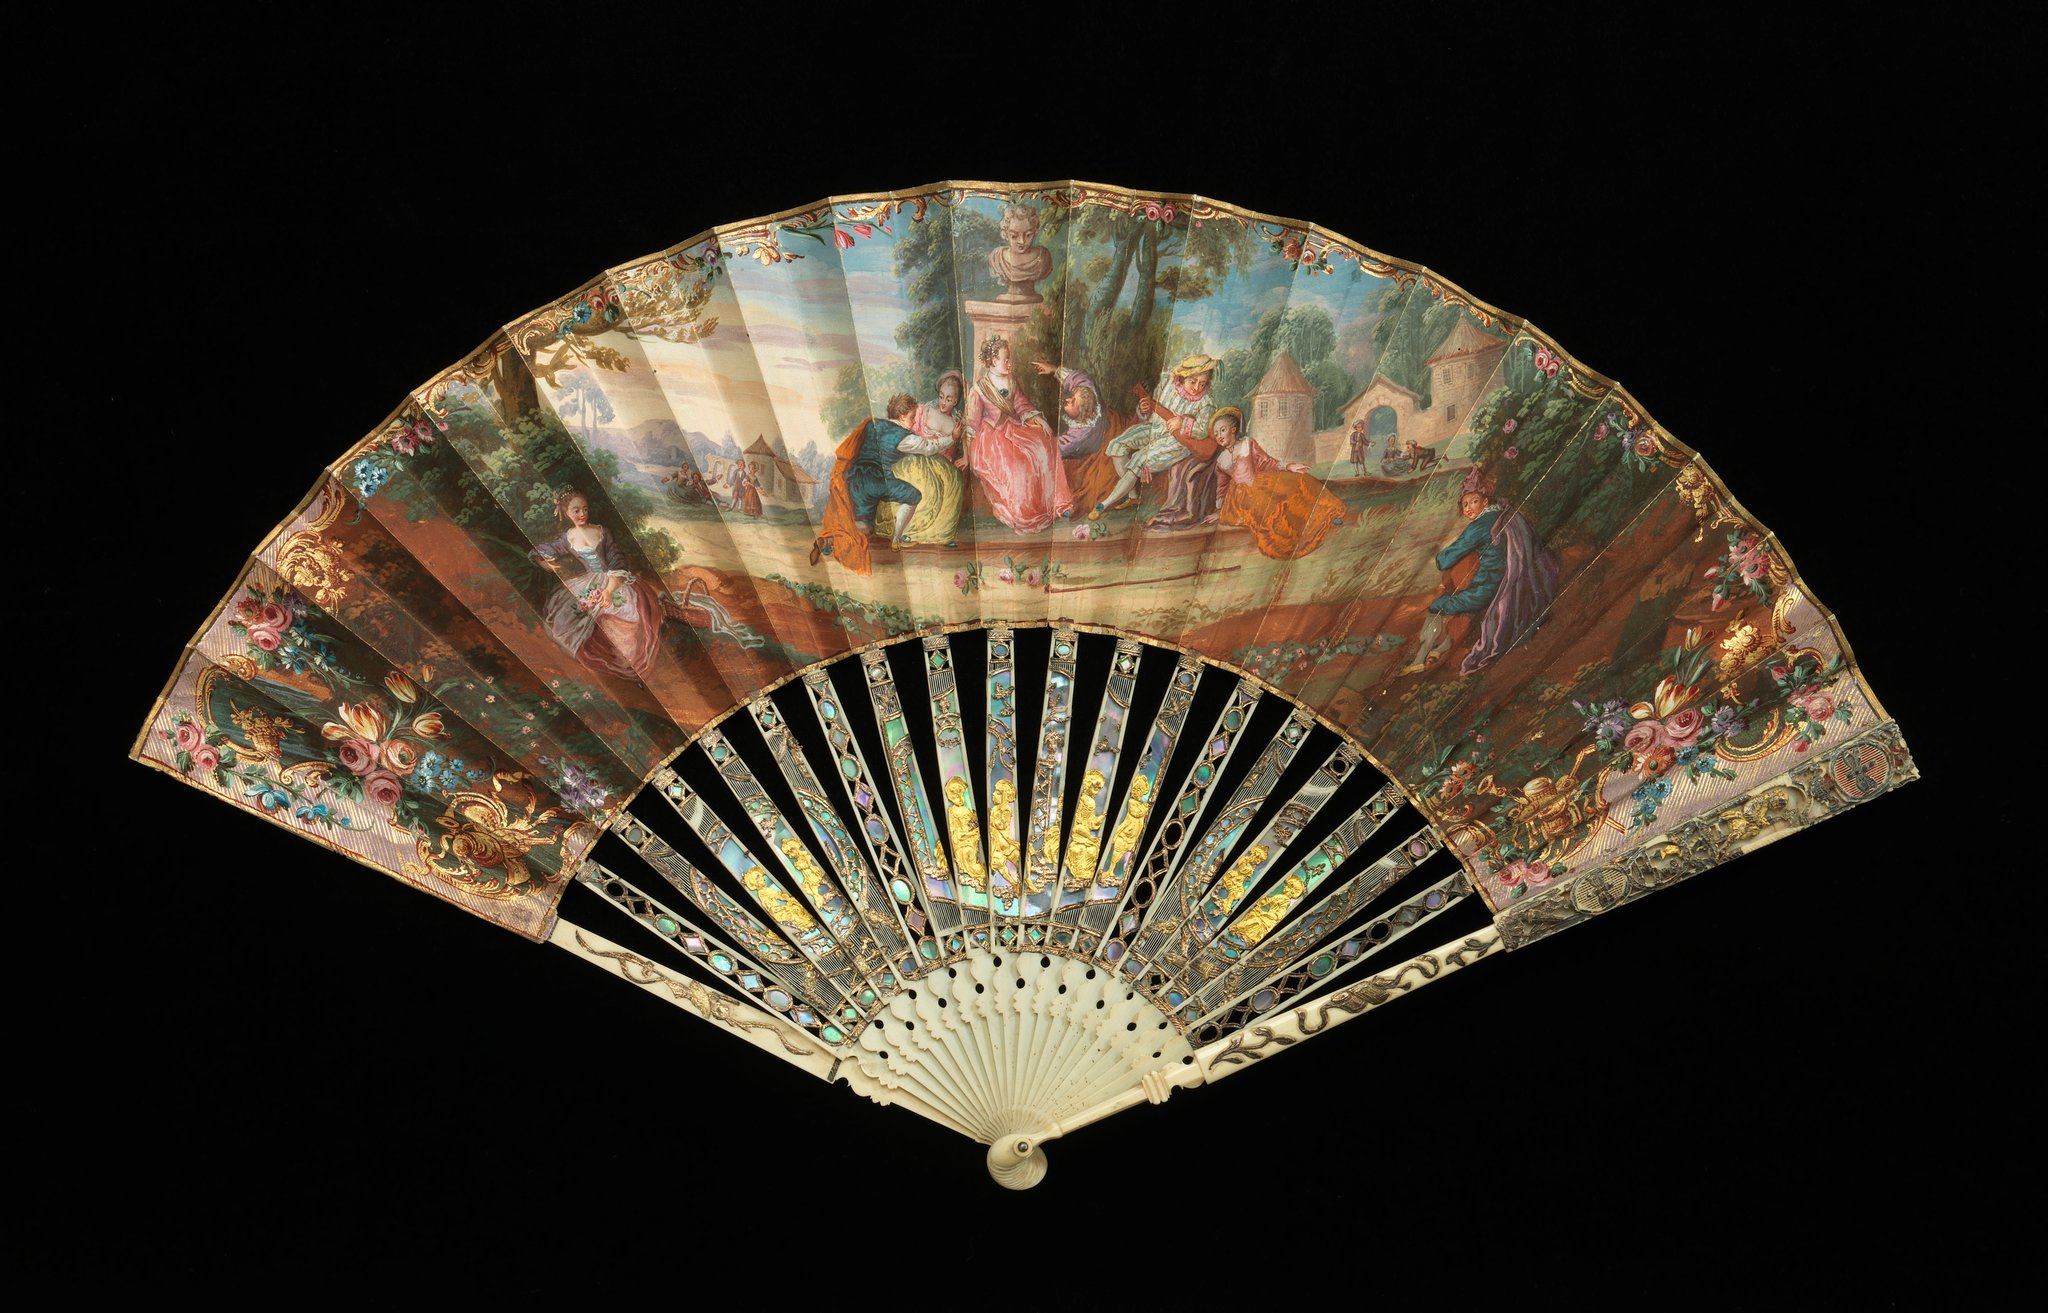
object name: fan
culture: german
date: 1751-1775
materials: gouache, ivory, metal, mother of pearl, parchment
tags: men,women